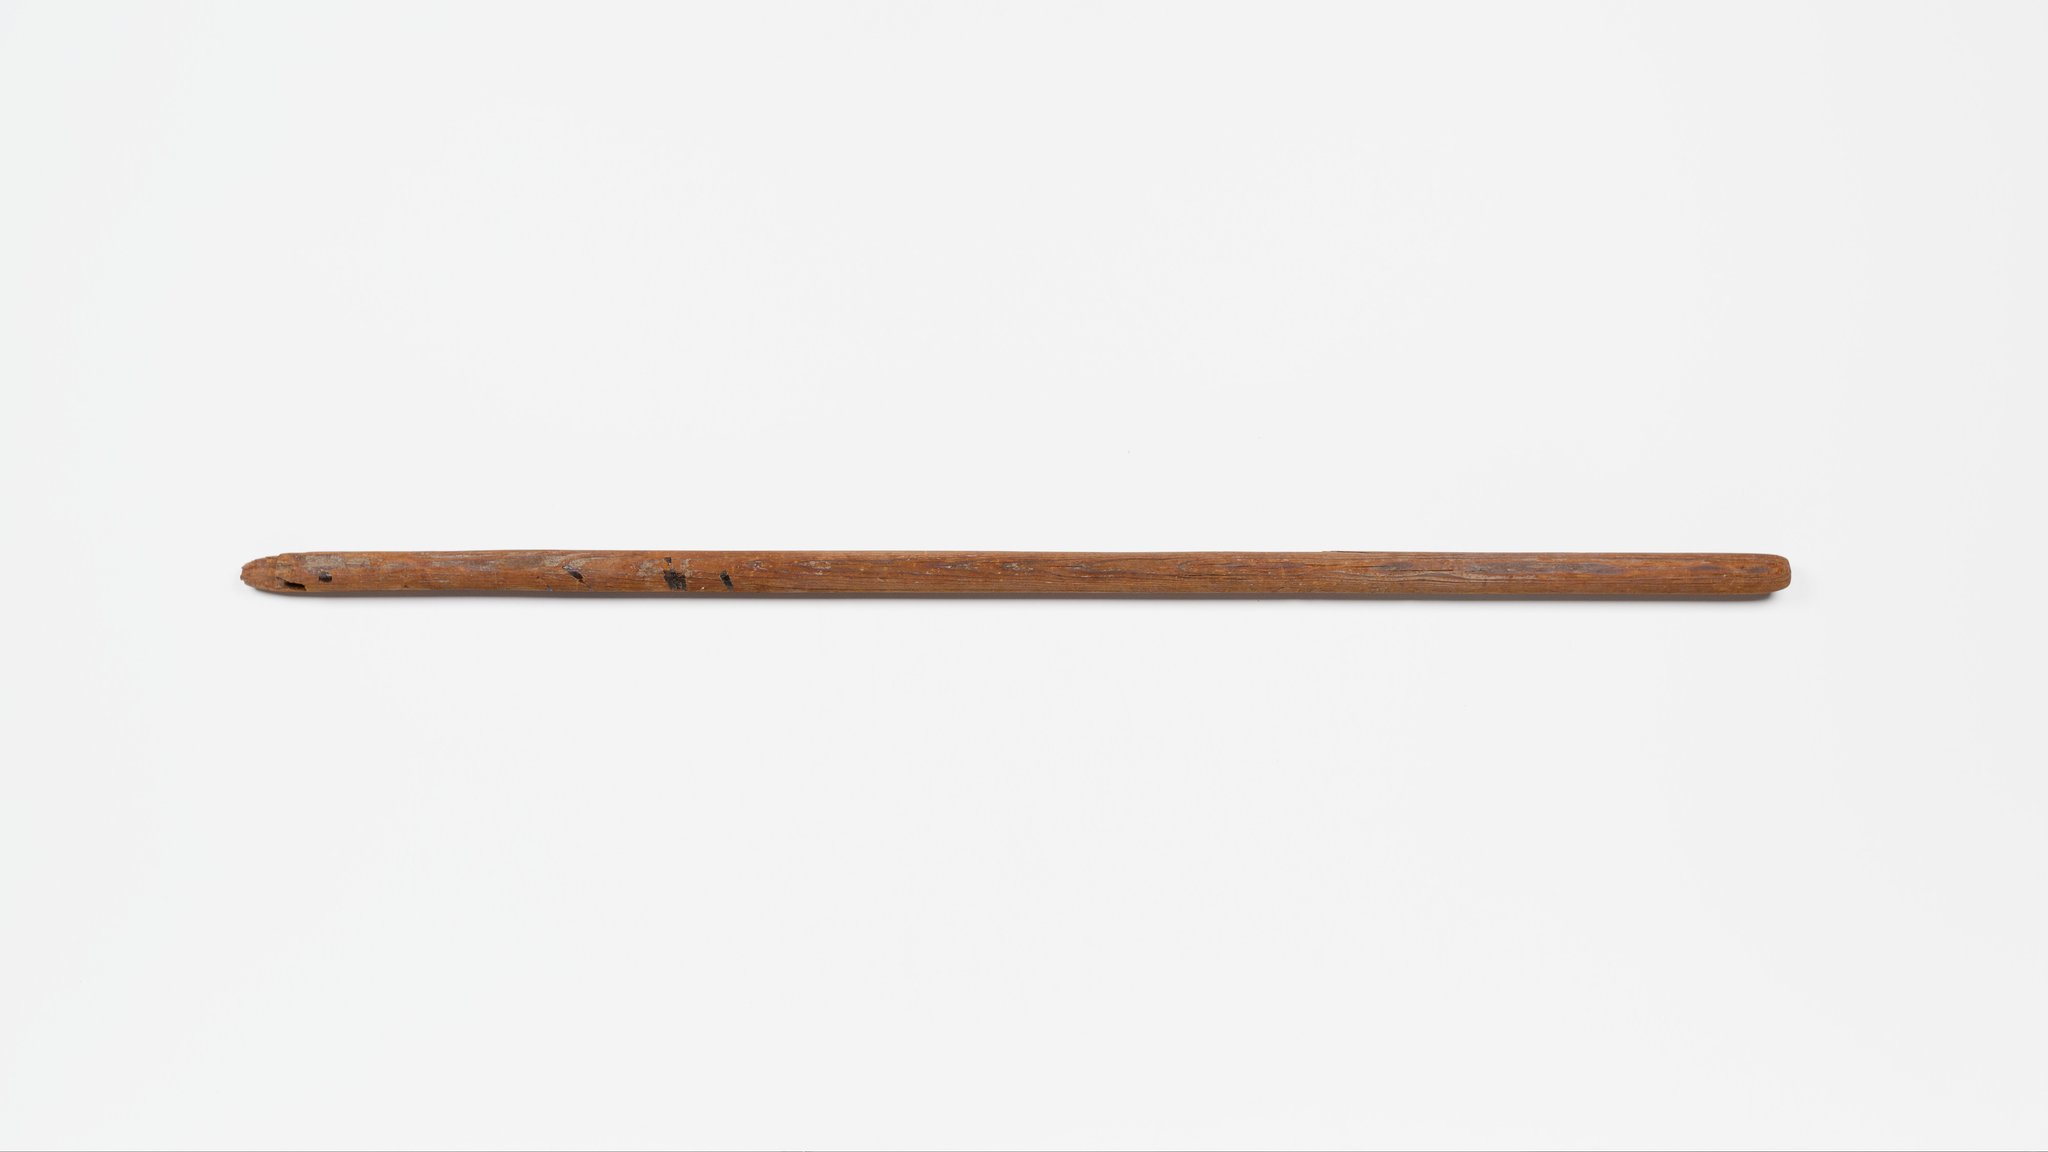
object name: staff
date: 1550-1295 BCE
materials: wood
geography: egypt